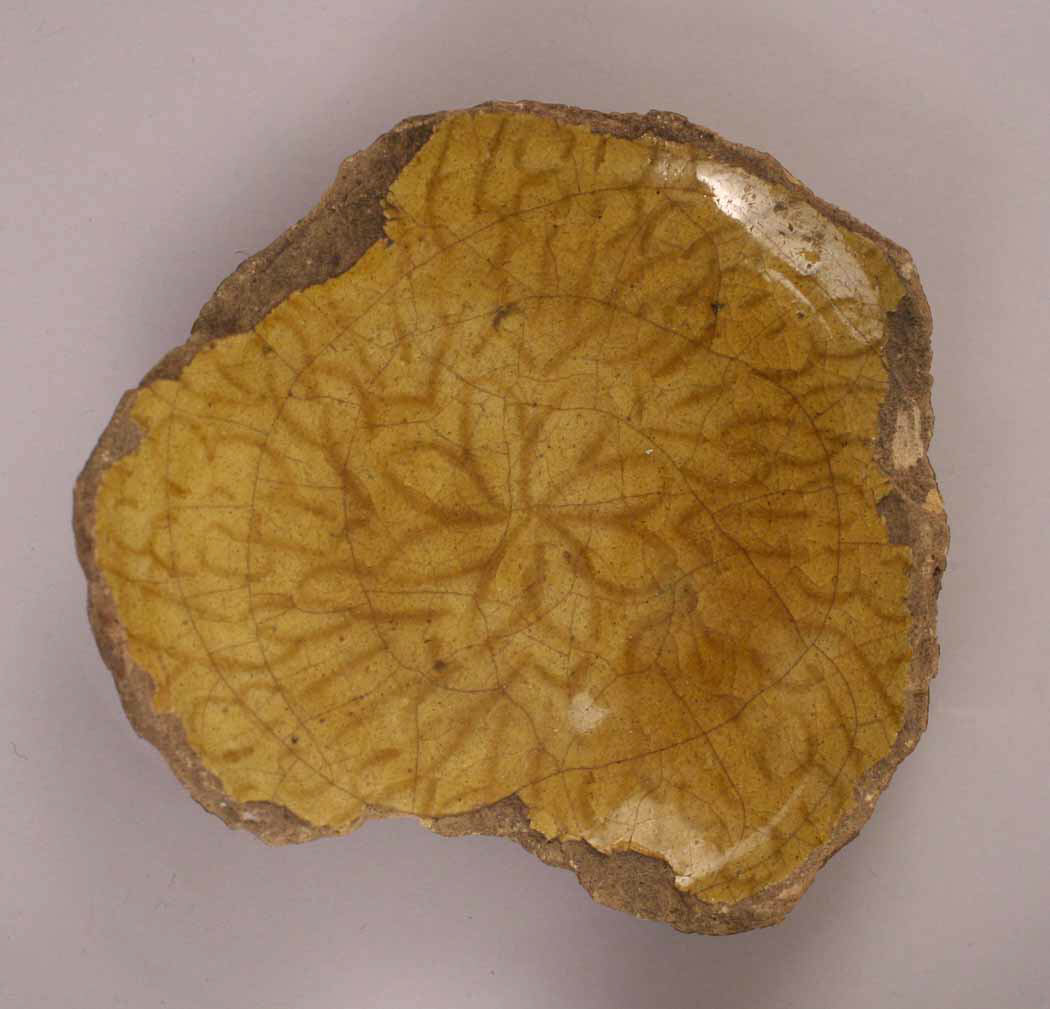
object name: ceramic fragment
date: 1201-1400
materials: earthenware, glaze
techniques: incising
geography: egypt